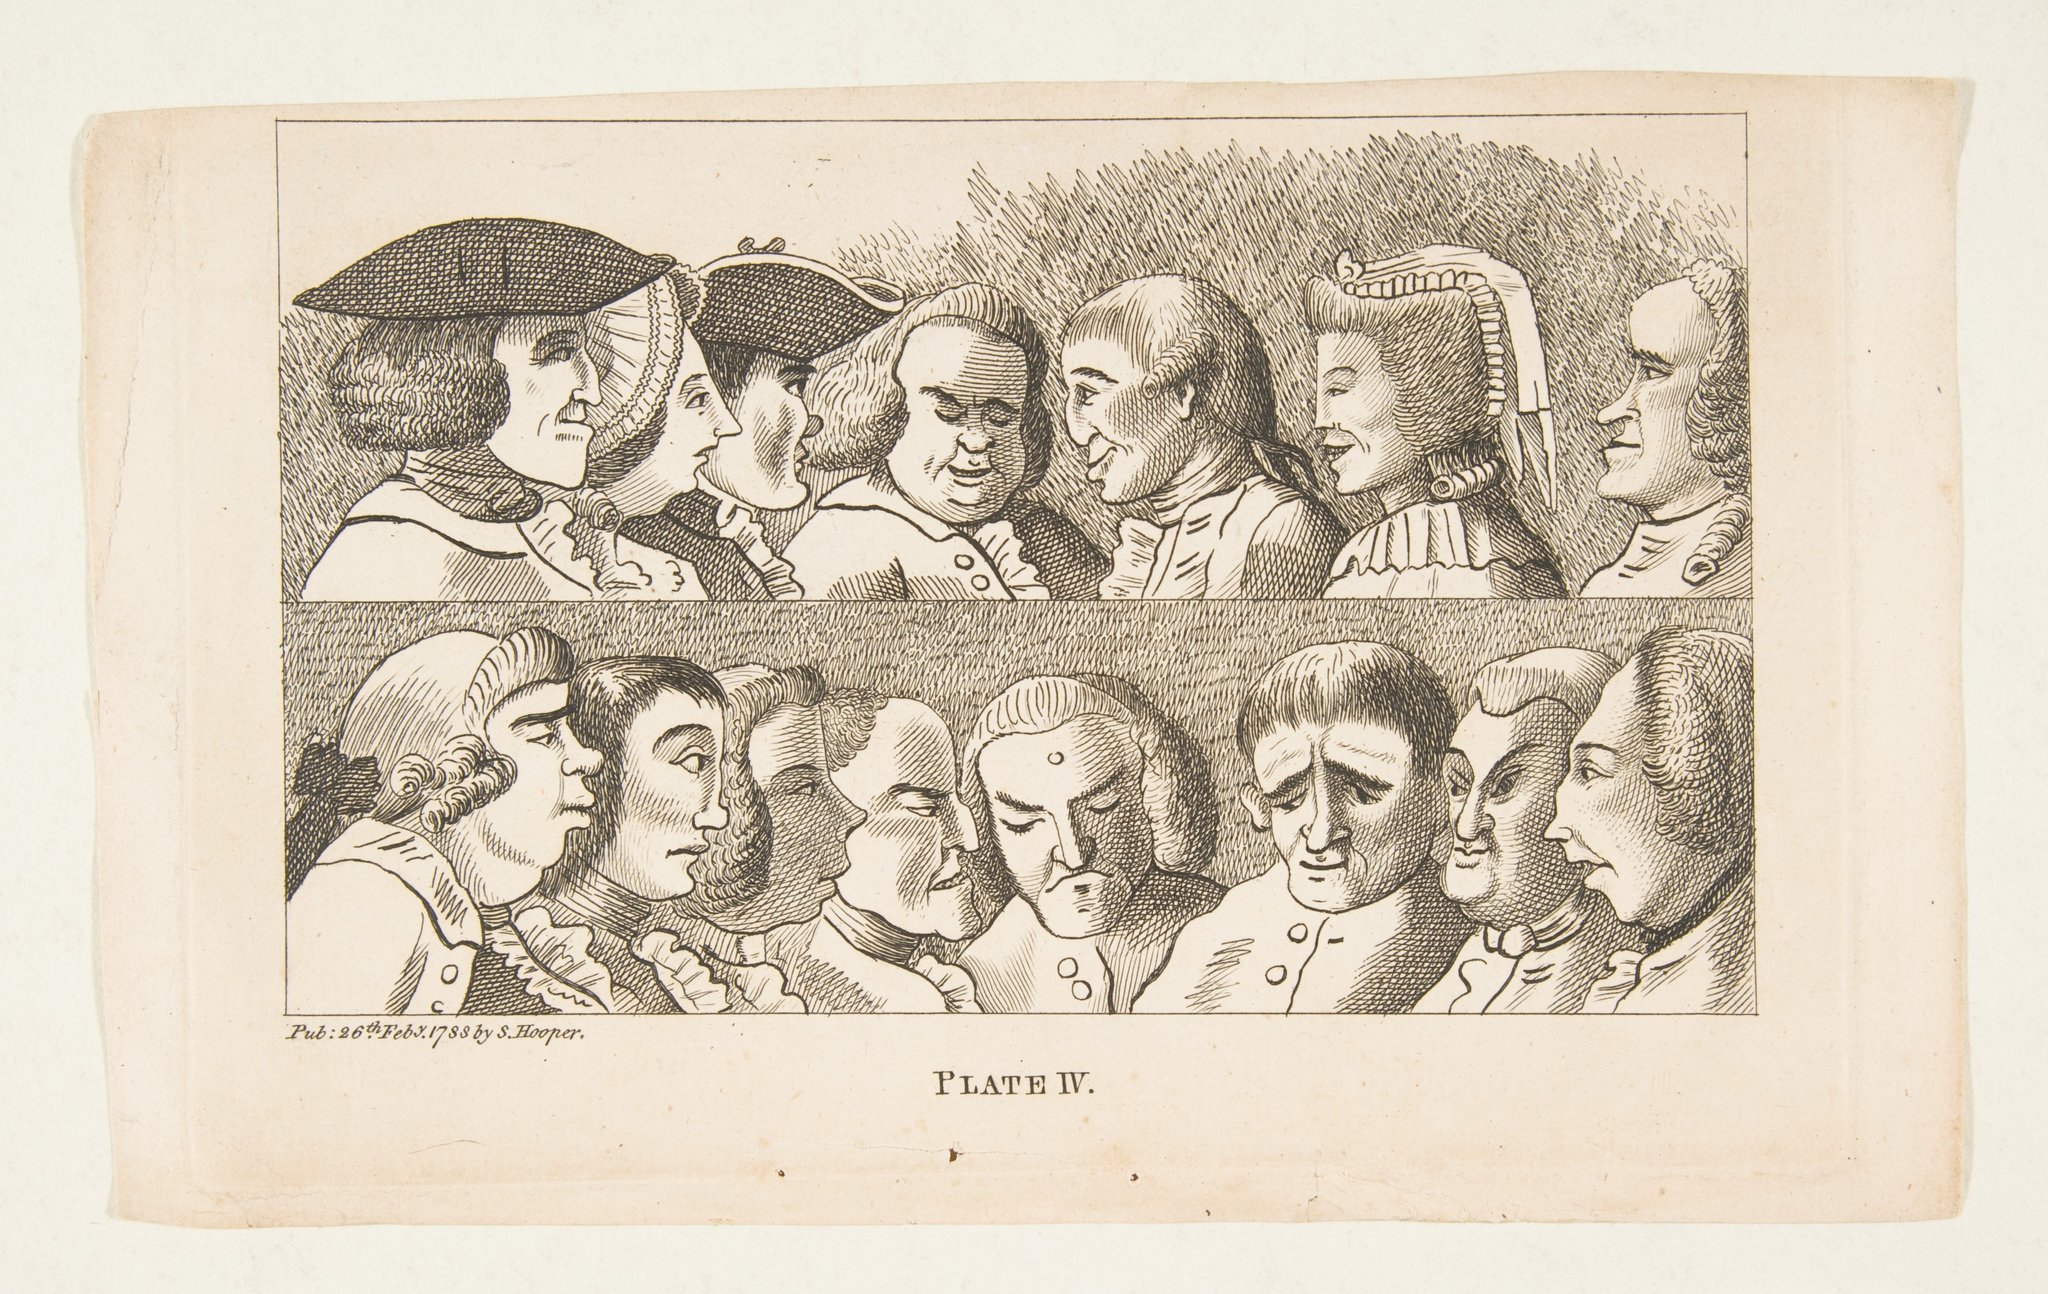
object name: print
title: Plate IV, from Rules for Drawing Caricaturas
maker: francis grose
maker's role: author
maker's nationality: british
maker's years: 1731-1791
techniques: etching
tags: men,profiles,women